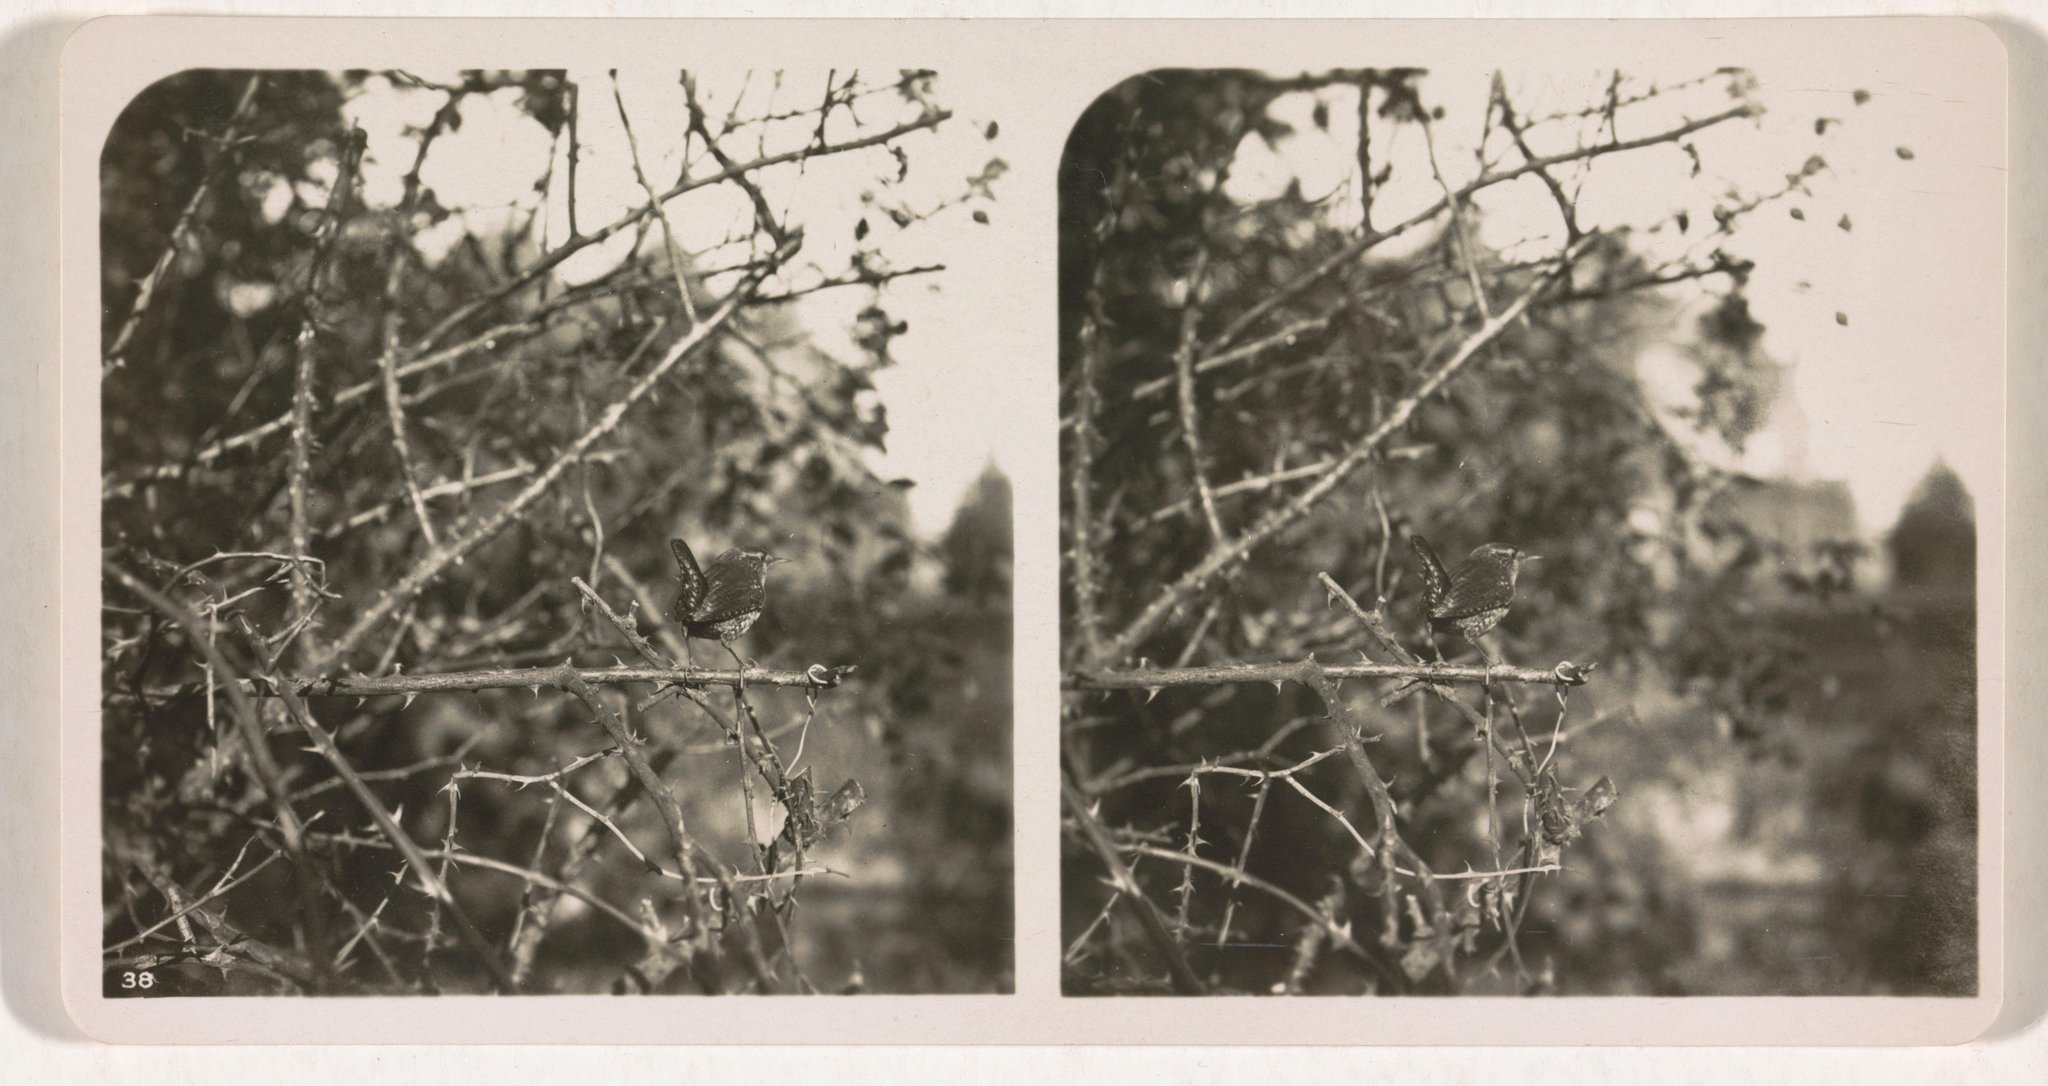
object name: stereograph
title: Winterkoninkje op tak van struik met doorns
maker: adolphe burdet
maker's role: fotograaf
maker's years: 1860-1940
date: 1870-1940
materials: photographic support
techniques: gelatin silver print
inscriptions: label: ‘38 / Troglodytes parvulus Koch / Troglodyte / Winterkoning...’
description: Linksonder op de foto links staat het nummer 38. Uit serie van 25 stereofoto's.